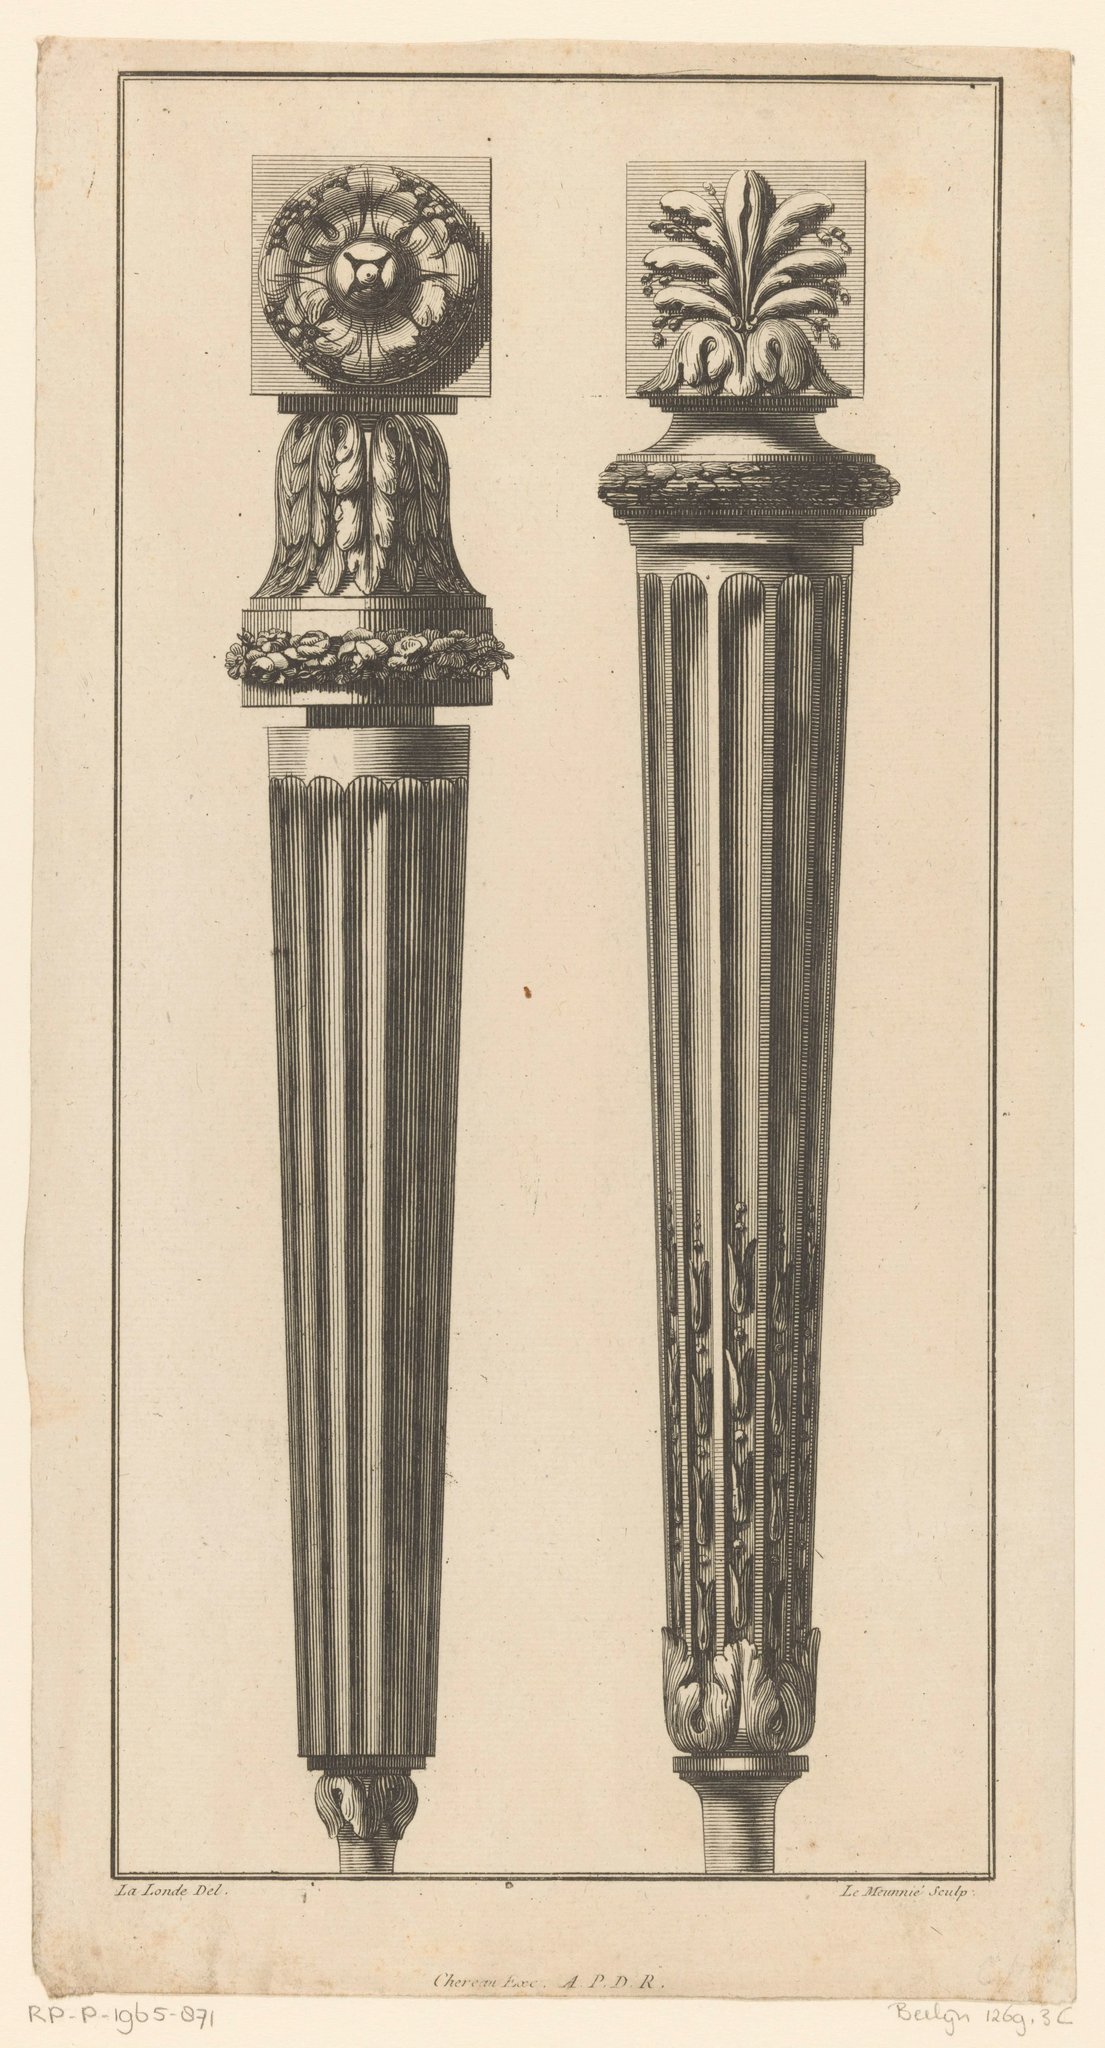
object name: ornament print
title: C Cahier de Pieds de Meubles à divers usages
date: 1784-1785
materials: paper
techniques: engraving, etching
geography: paris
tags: furniture and household effects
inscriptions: collector's mark: Lugt 2228, collector's mark: Lugt 2760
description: Twee geornamenteerde meubelpoten met bladmotieven.